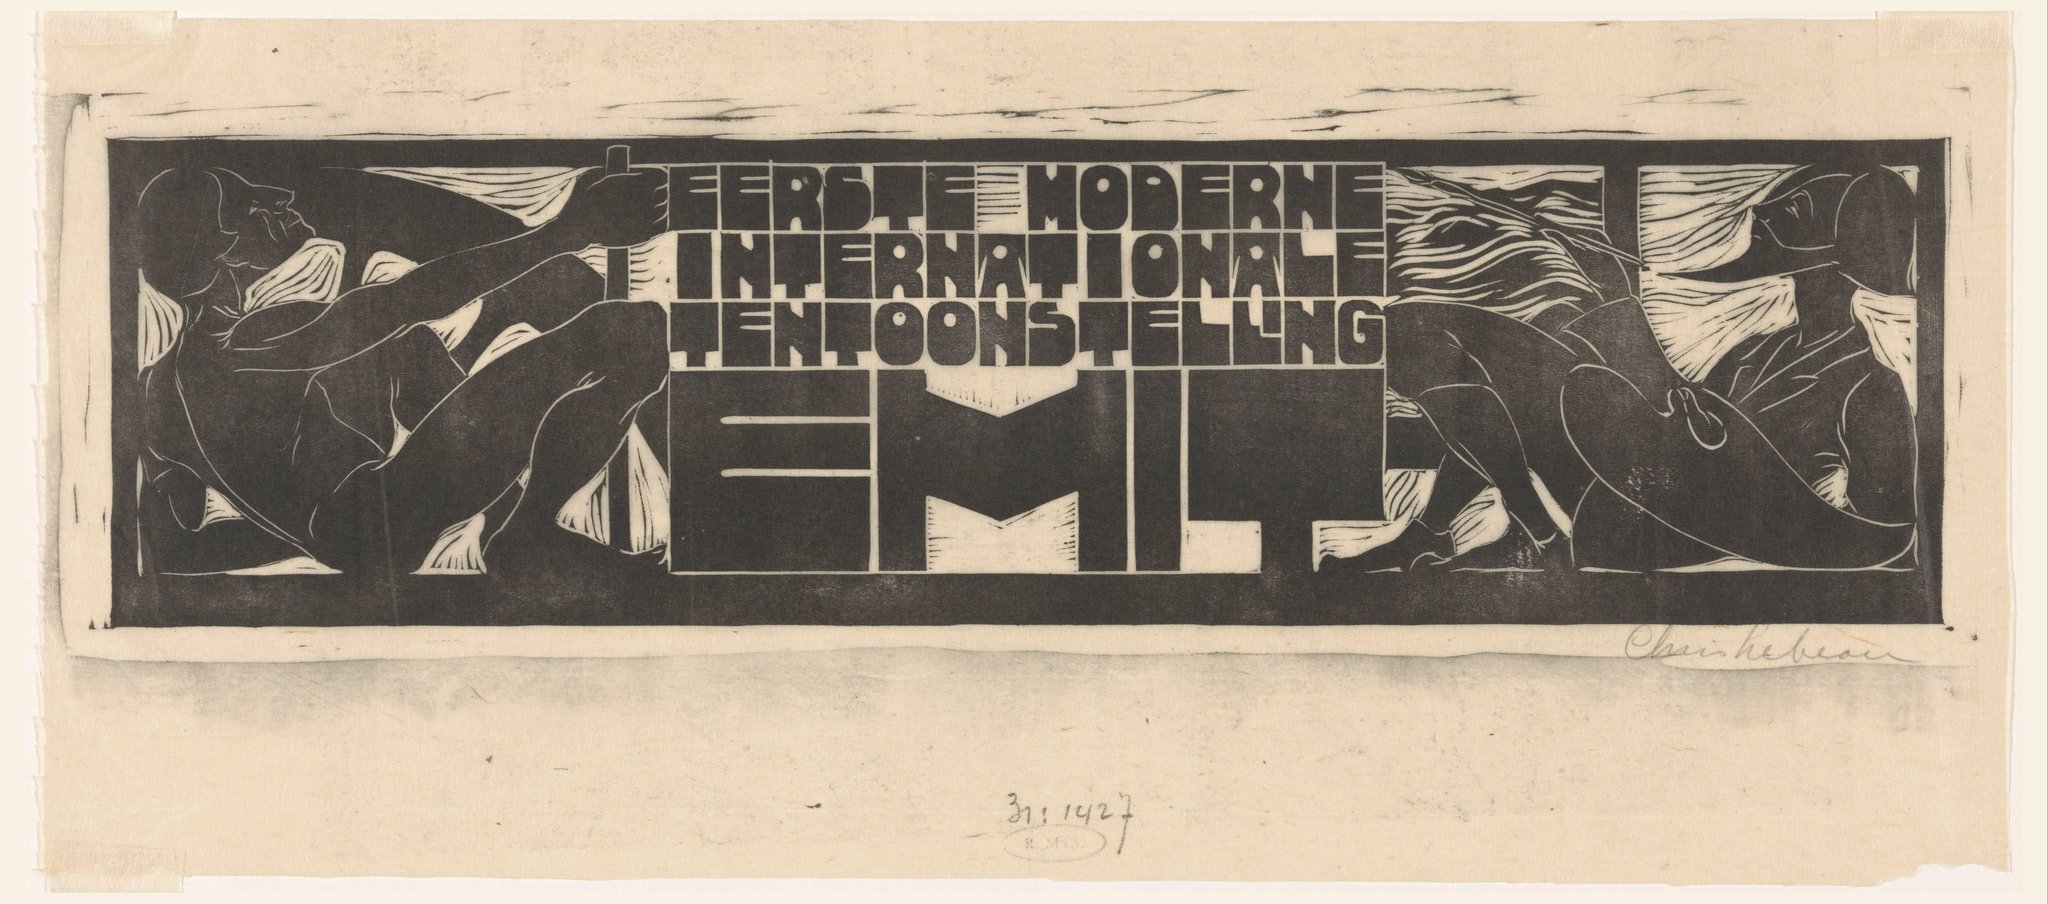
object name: print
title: Aankondiging of titelhoofd voor de Eerste Moderne Internationale Tentoonstelling (EMIT) te Scheveningen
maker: chris lebeau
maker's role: draughtsman, print maker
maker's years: 1878-1945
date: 1923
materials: paper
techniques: woodcut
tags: exhibition ~ art, painter working from nude model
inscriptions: collector's mark: Lugt 2228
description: Links ligt een naaktmodel; rechts een schilder met penseel en palet in de hand.